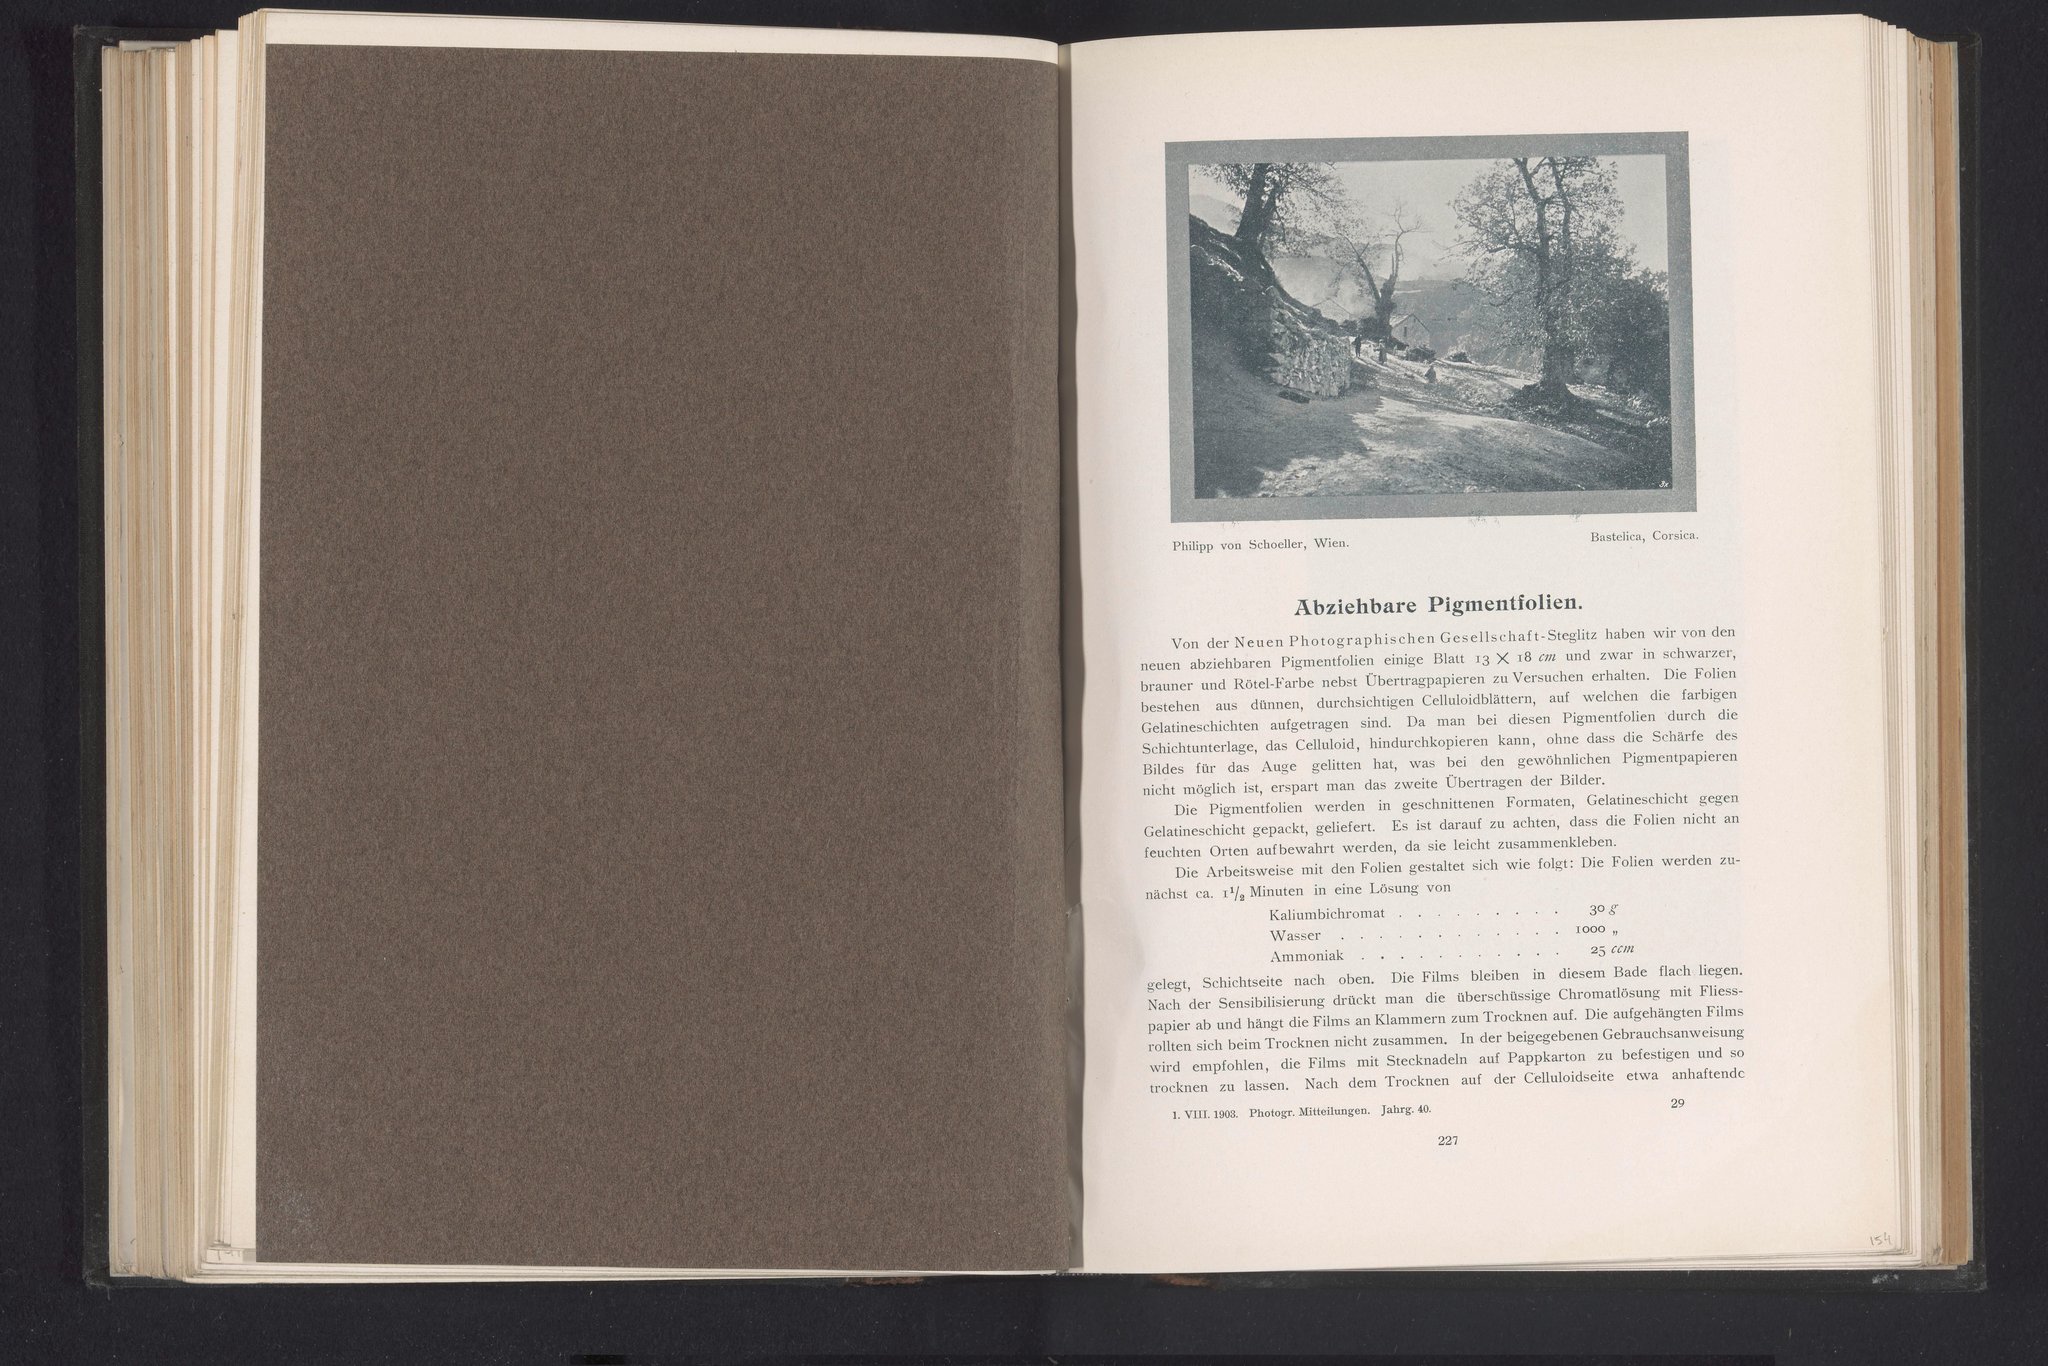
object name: photomechanical print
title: Bastelica, Corsica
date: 1898-1903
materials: paper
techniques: autotype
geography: bastelica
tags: canal, bridge in city across river, canal, etc.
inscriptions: monogram: ‘BX’